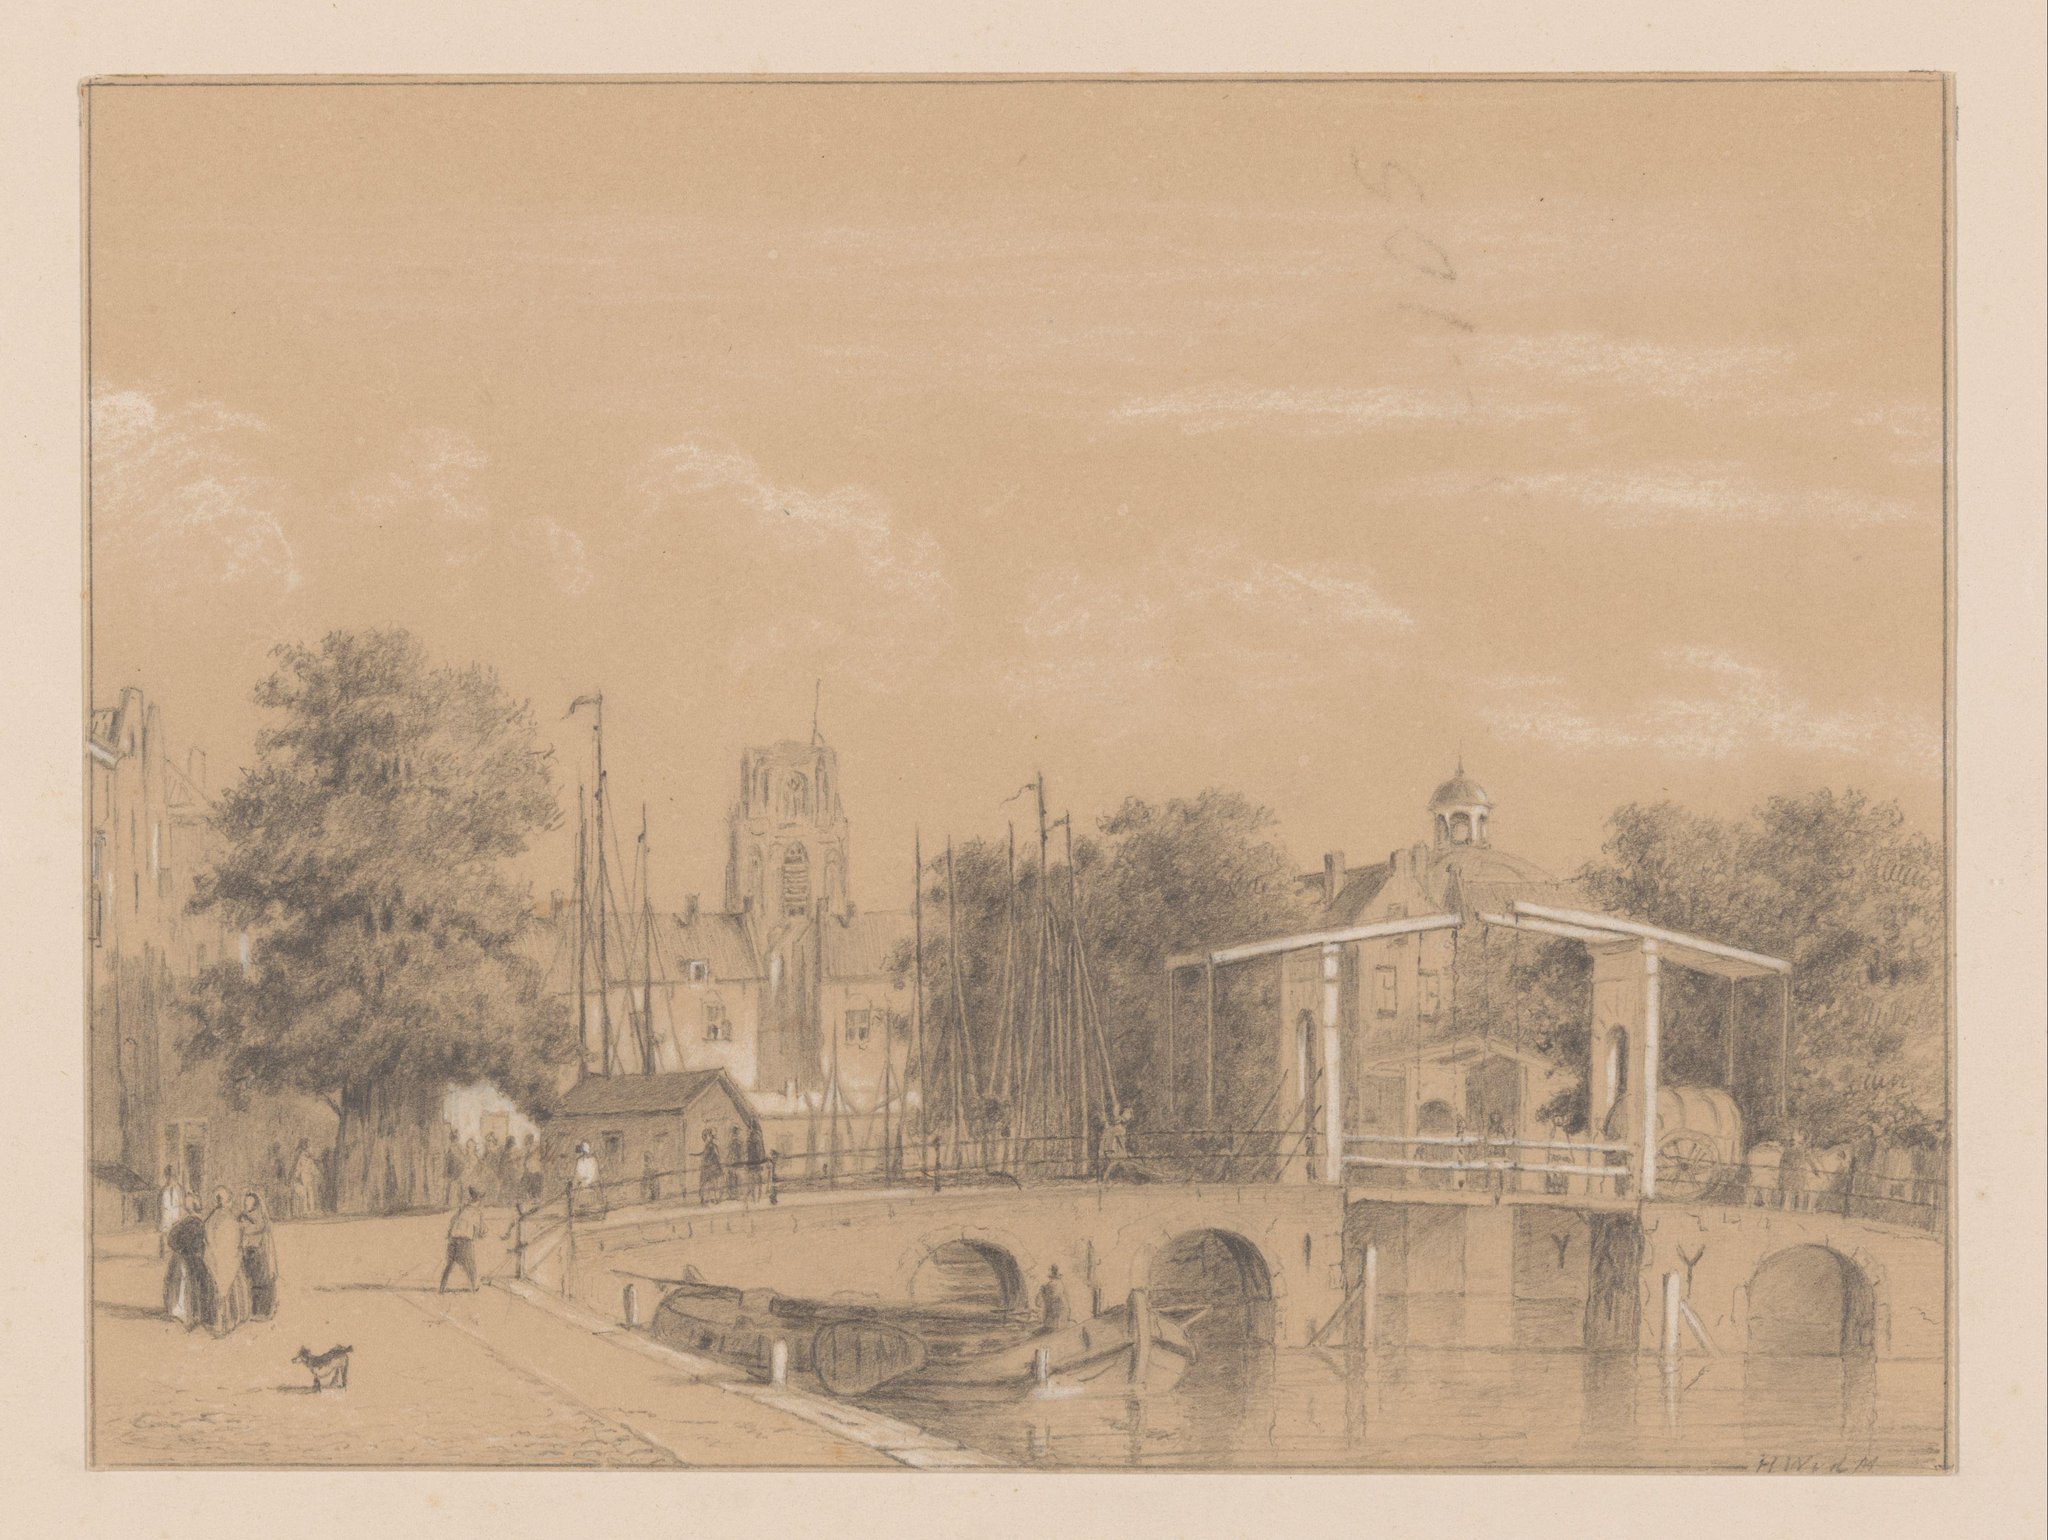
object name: drawing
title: Stadsgezicht in Rotterdam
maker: monogrammist hwvdm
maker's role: draughtsman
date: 1700-1850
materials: paper, pencil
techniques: drawing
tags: sailing-ship, sailing-boat, city-view in general; 'veduta', bridge in city across river, canal, etc., rotterdam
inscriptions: collector's mark: Lugt 2228